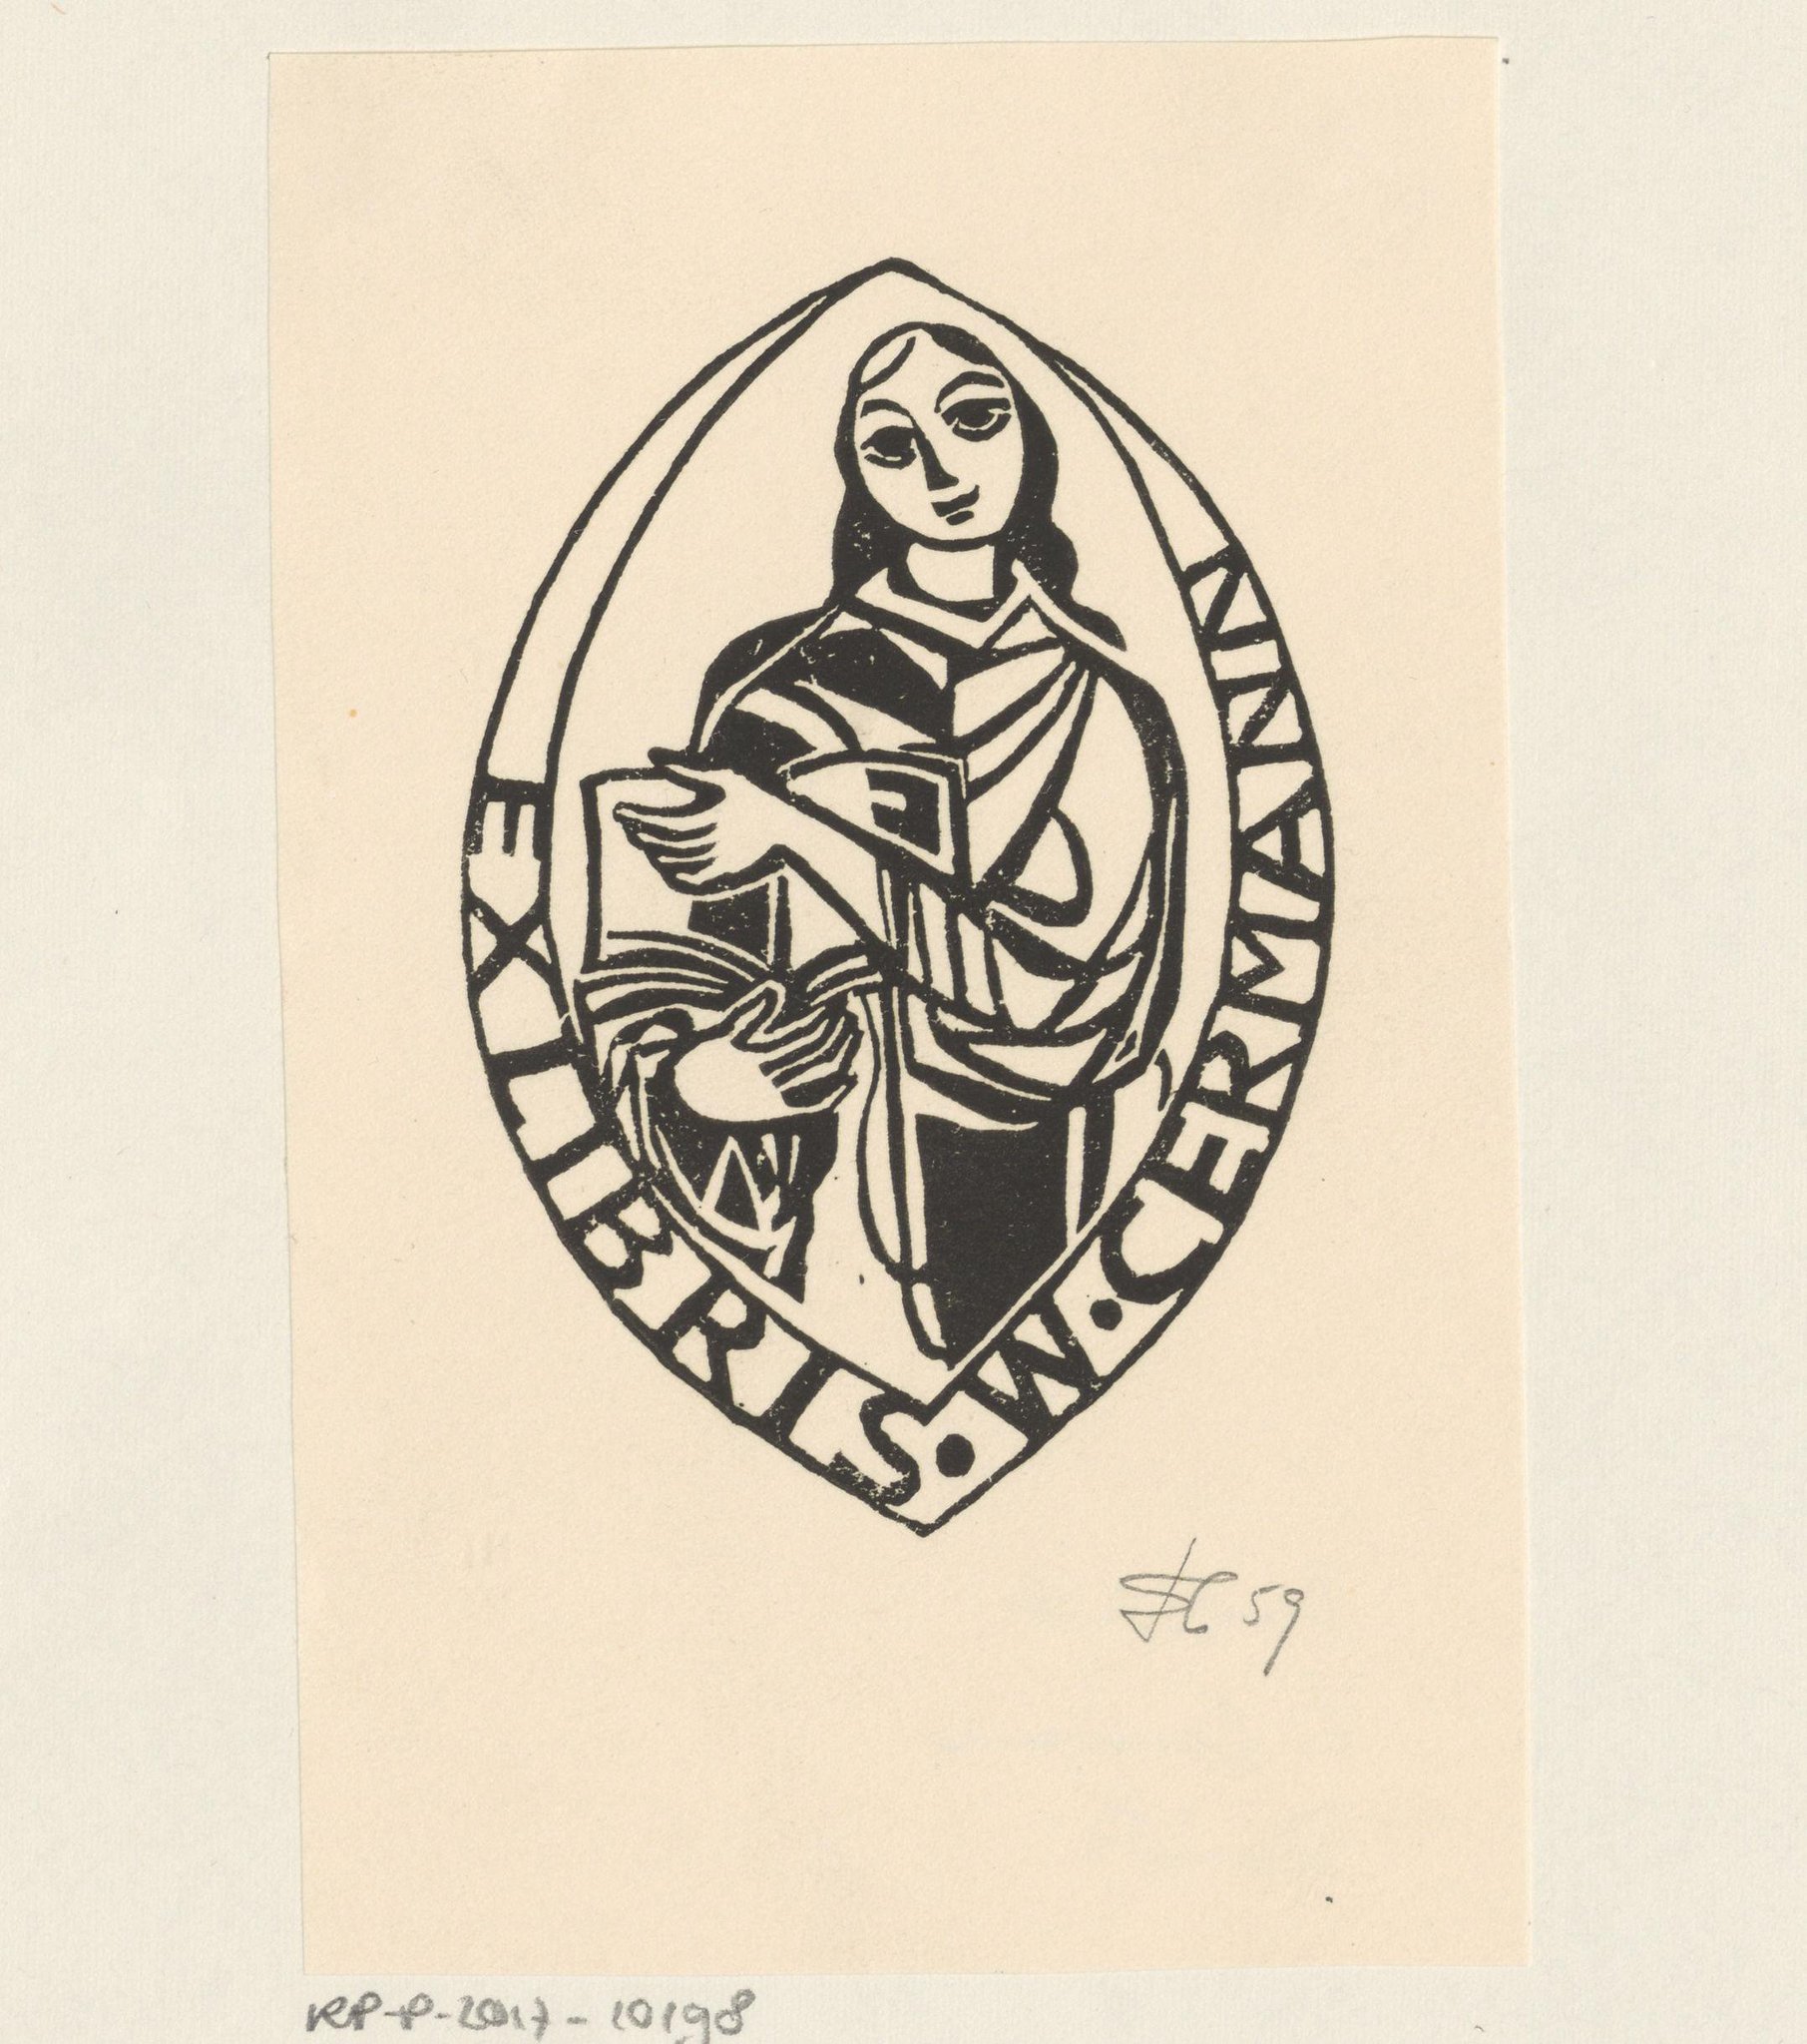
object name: bookplate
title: Ex libris van W. Cermann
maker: f. cermann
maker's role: print maker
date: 1959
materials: paper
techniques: linocut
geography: germany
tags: book, standing figure - aa - female human figure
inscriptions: monogram and date: ‘FC 59’